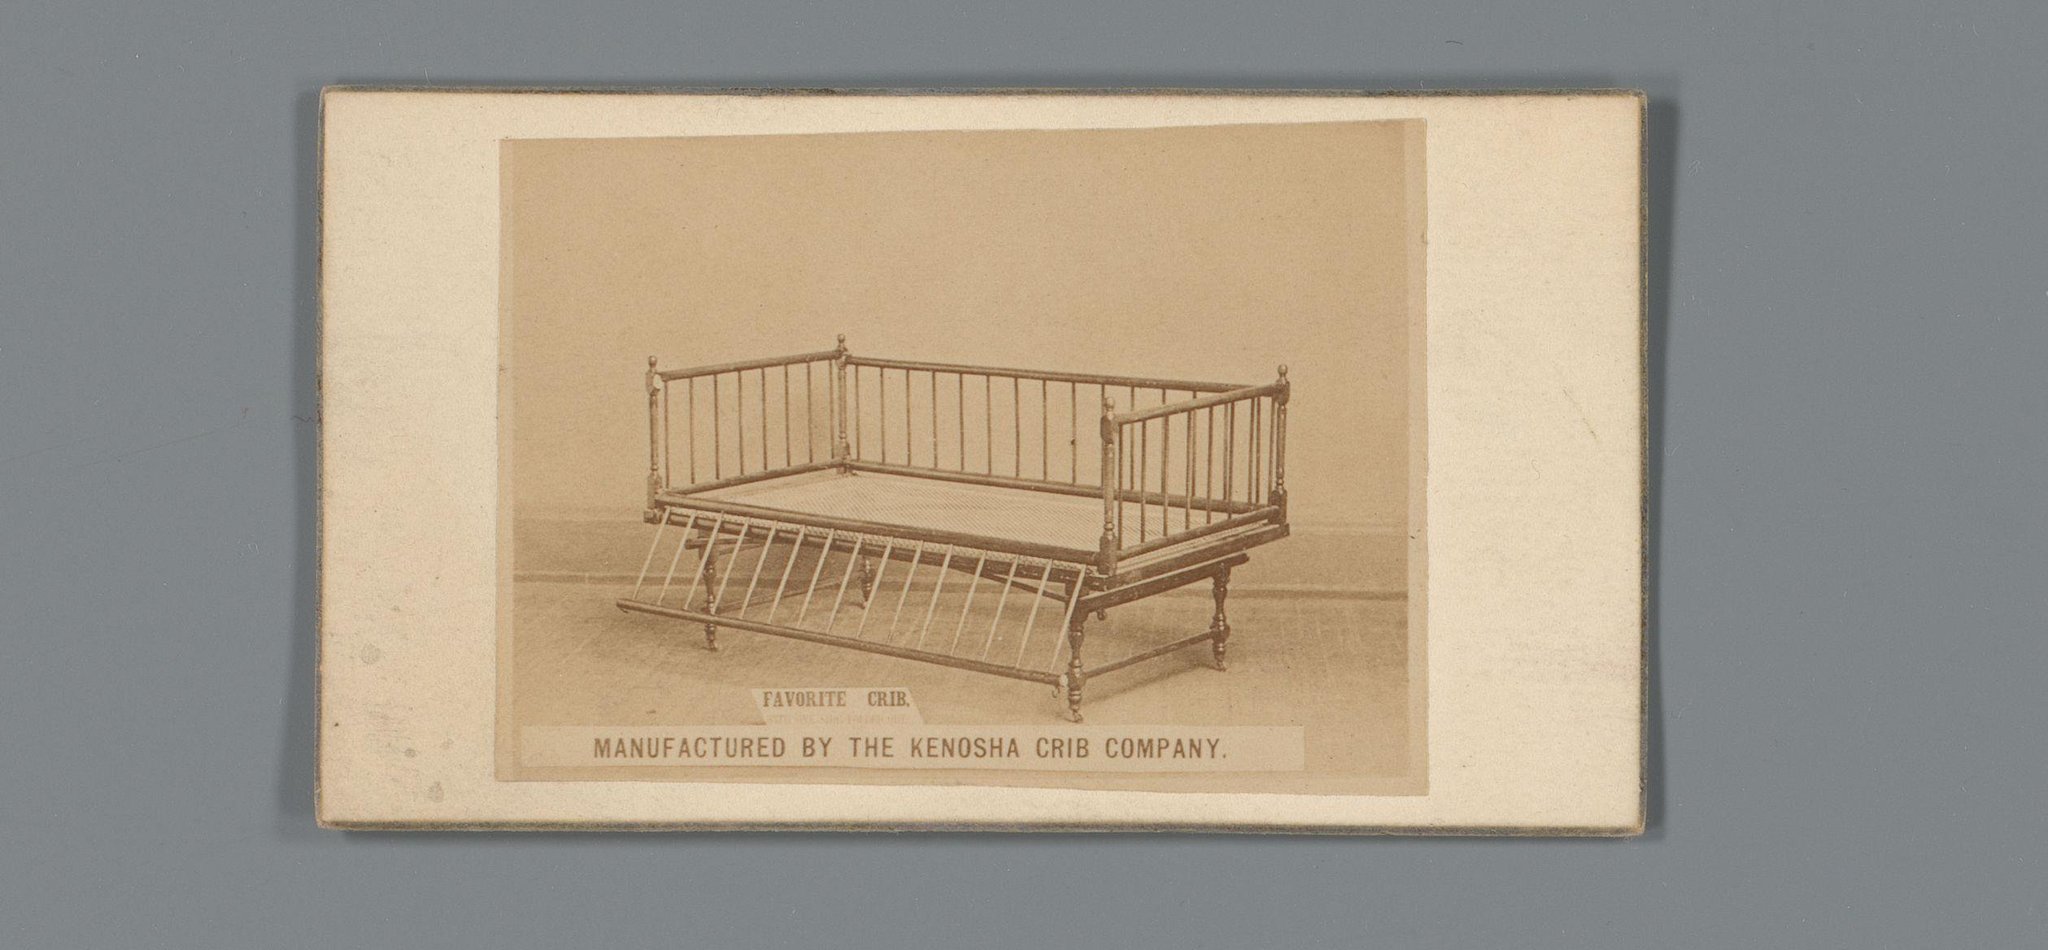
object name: photograph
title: Favorite crib manufactured by the Kenosha Crib Company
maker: Anonymous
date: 1850-1915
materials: cardboard, photographic support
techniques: albumen print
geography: chicago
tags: advertising, cradle, crib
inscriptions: inscription: ‘COMPLIMENTS OF/ AMES & FROST CO./ 302 WABASH AVENUE./ CHICAGO, -- ILL./ PRICES ON APPLICATION’